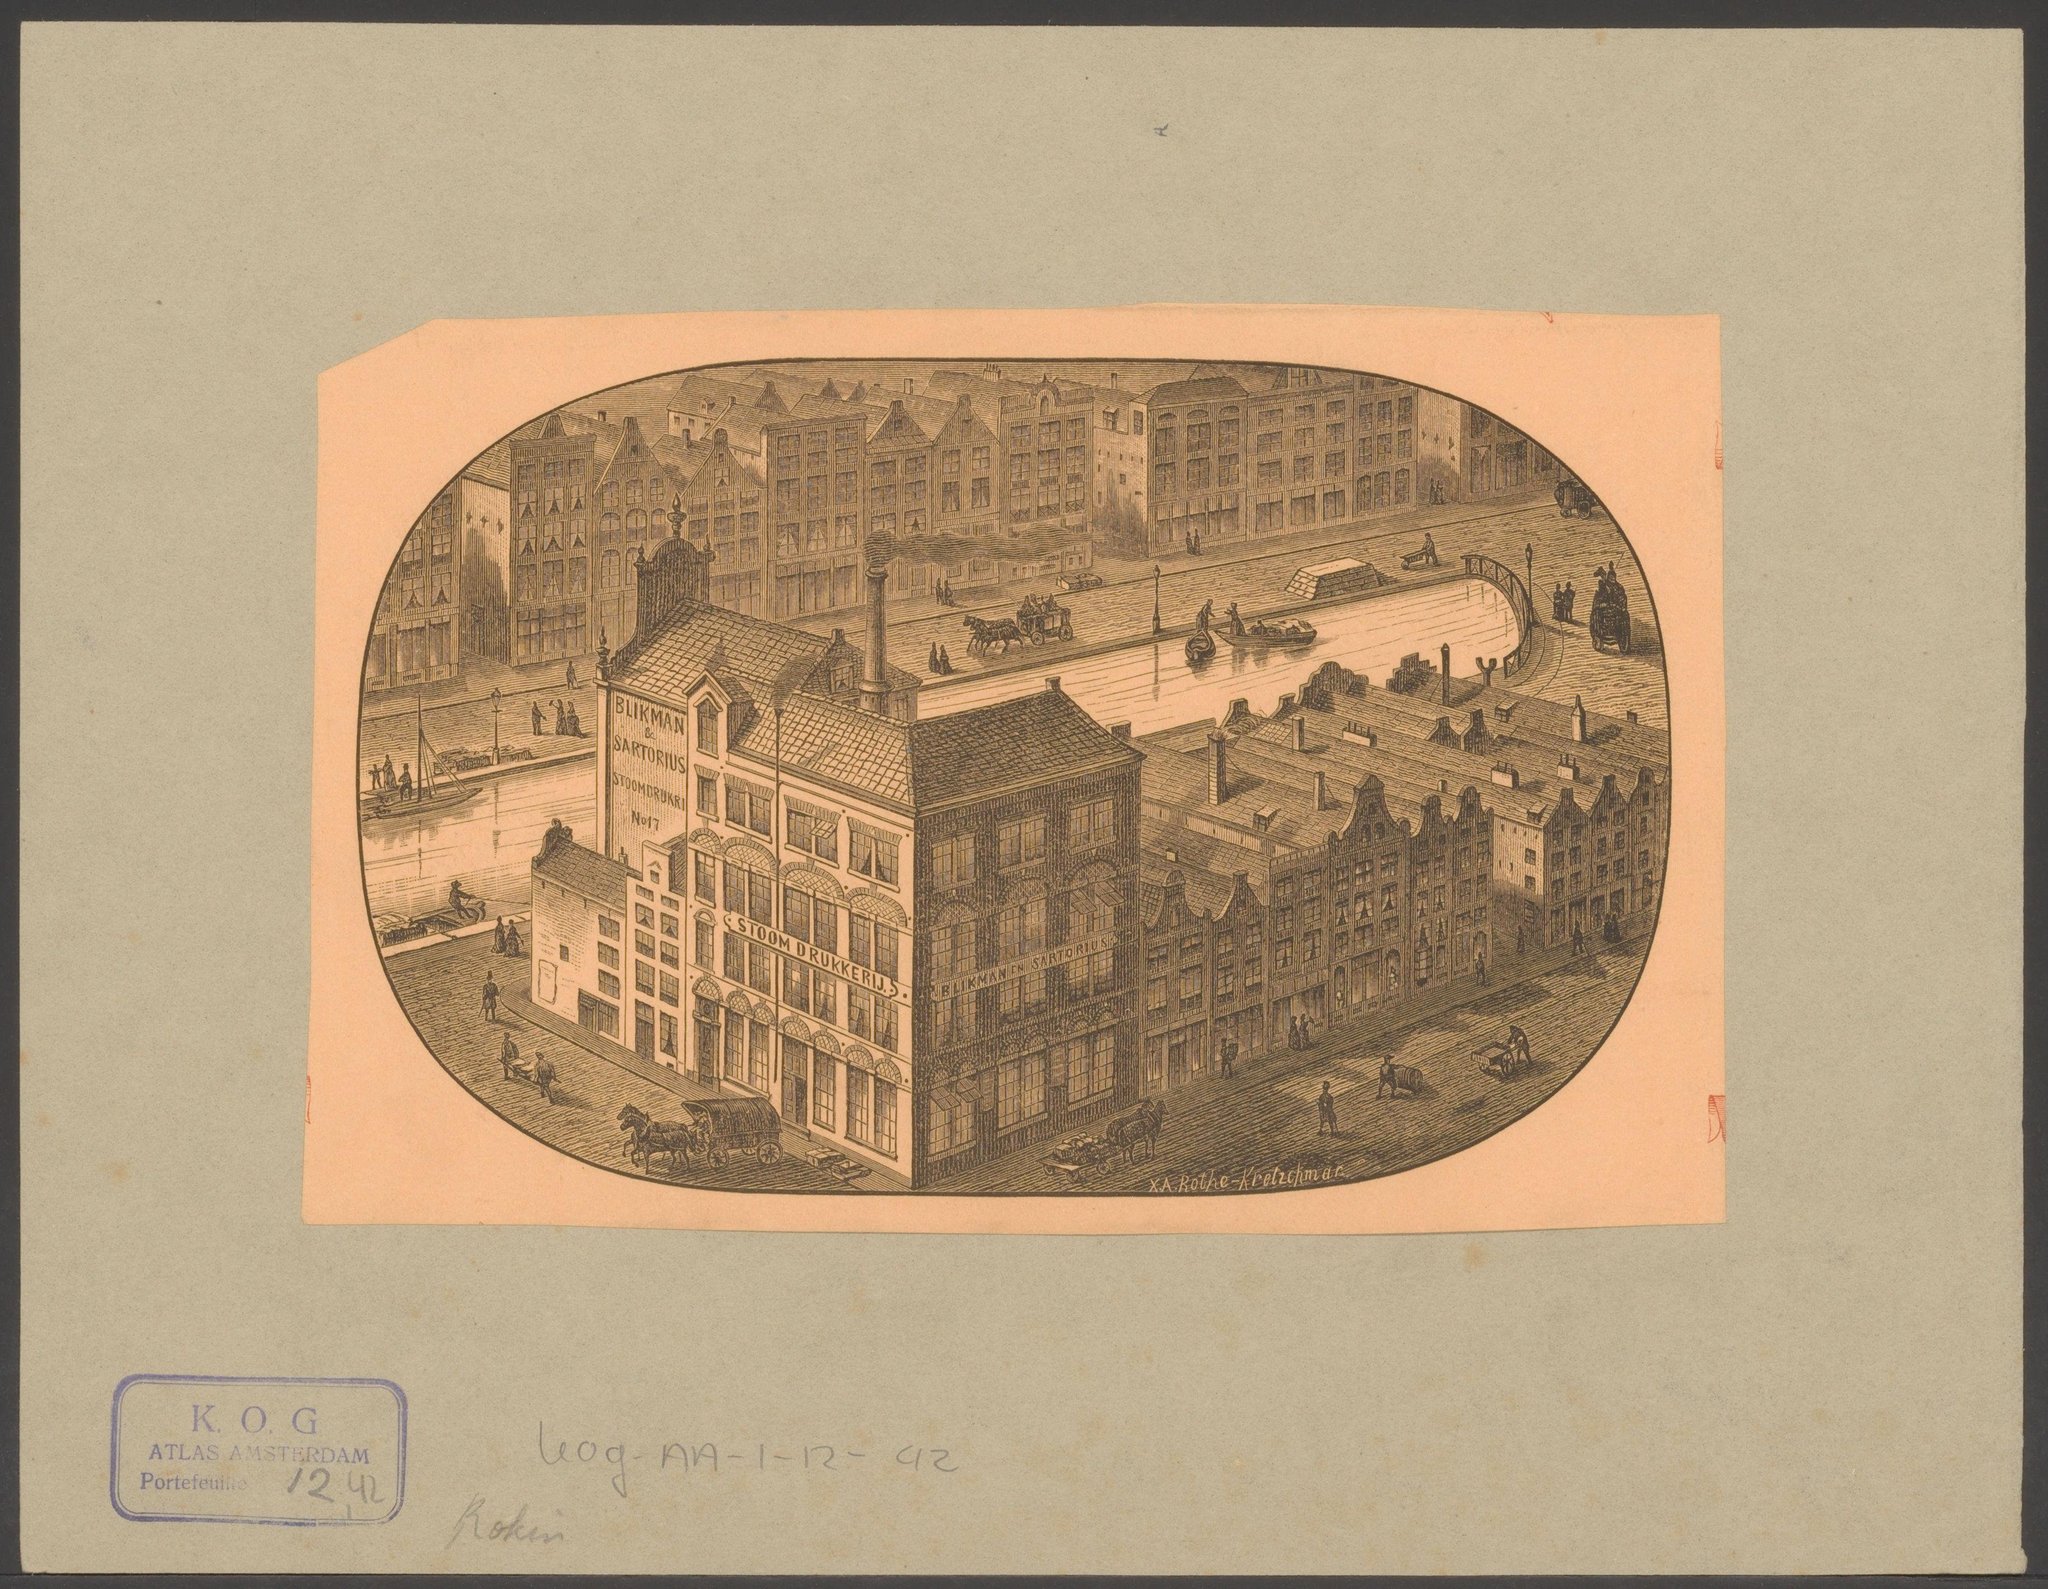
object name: print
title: Gezicht op de drukkerij van Blikman & Sartorius aan het Rokin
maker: eduard kretzschmar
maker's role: print maker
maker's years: 1807-1858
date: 1817-1858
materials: paper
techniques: engraving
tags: city-view in general; 'veduta', canal, printing, printing office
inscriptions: collector's mark: ‘12,42’ Lugt 1641b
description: Onderwerpsrubriek binnen de Atlas Amsterdam: Rokin, Rotterdammersloot, Rozengang, Rozengracht, Rozenstraat, Rusland, Rustenburgerstraat, Ruysdaelkade, Ruysdaelstraat, Ruyterkade (de), Ruyterweg (Admiraal de).